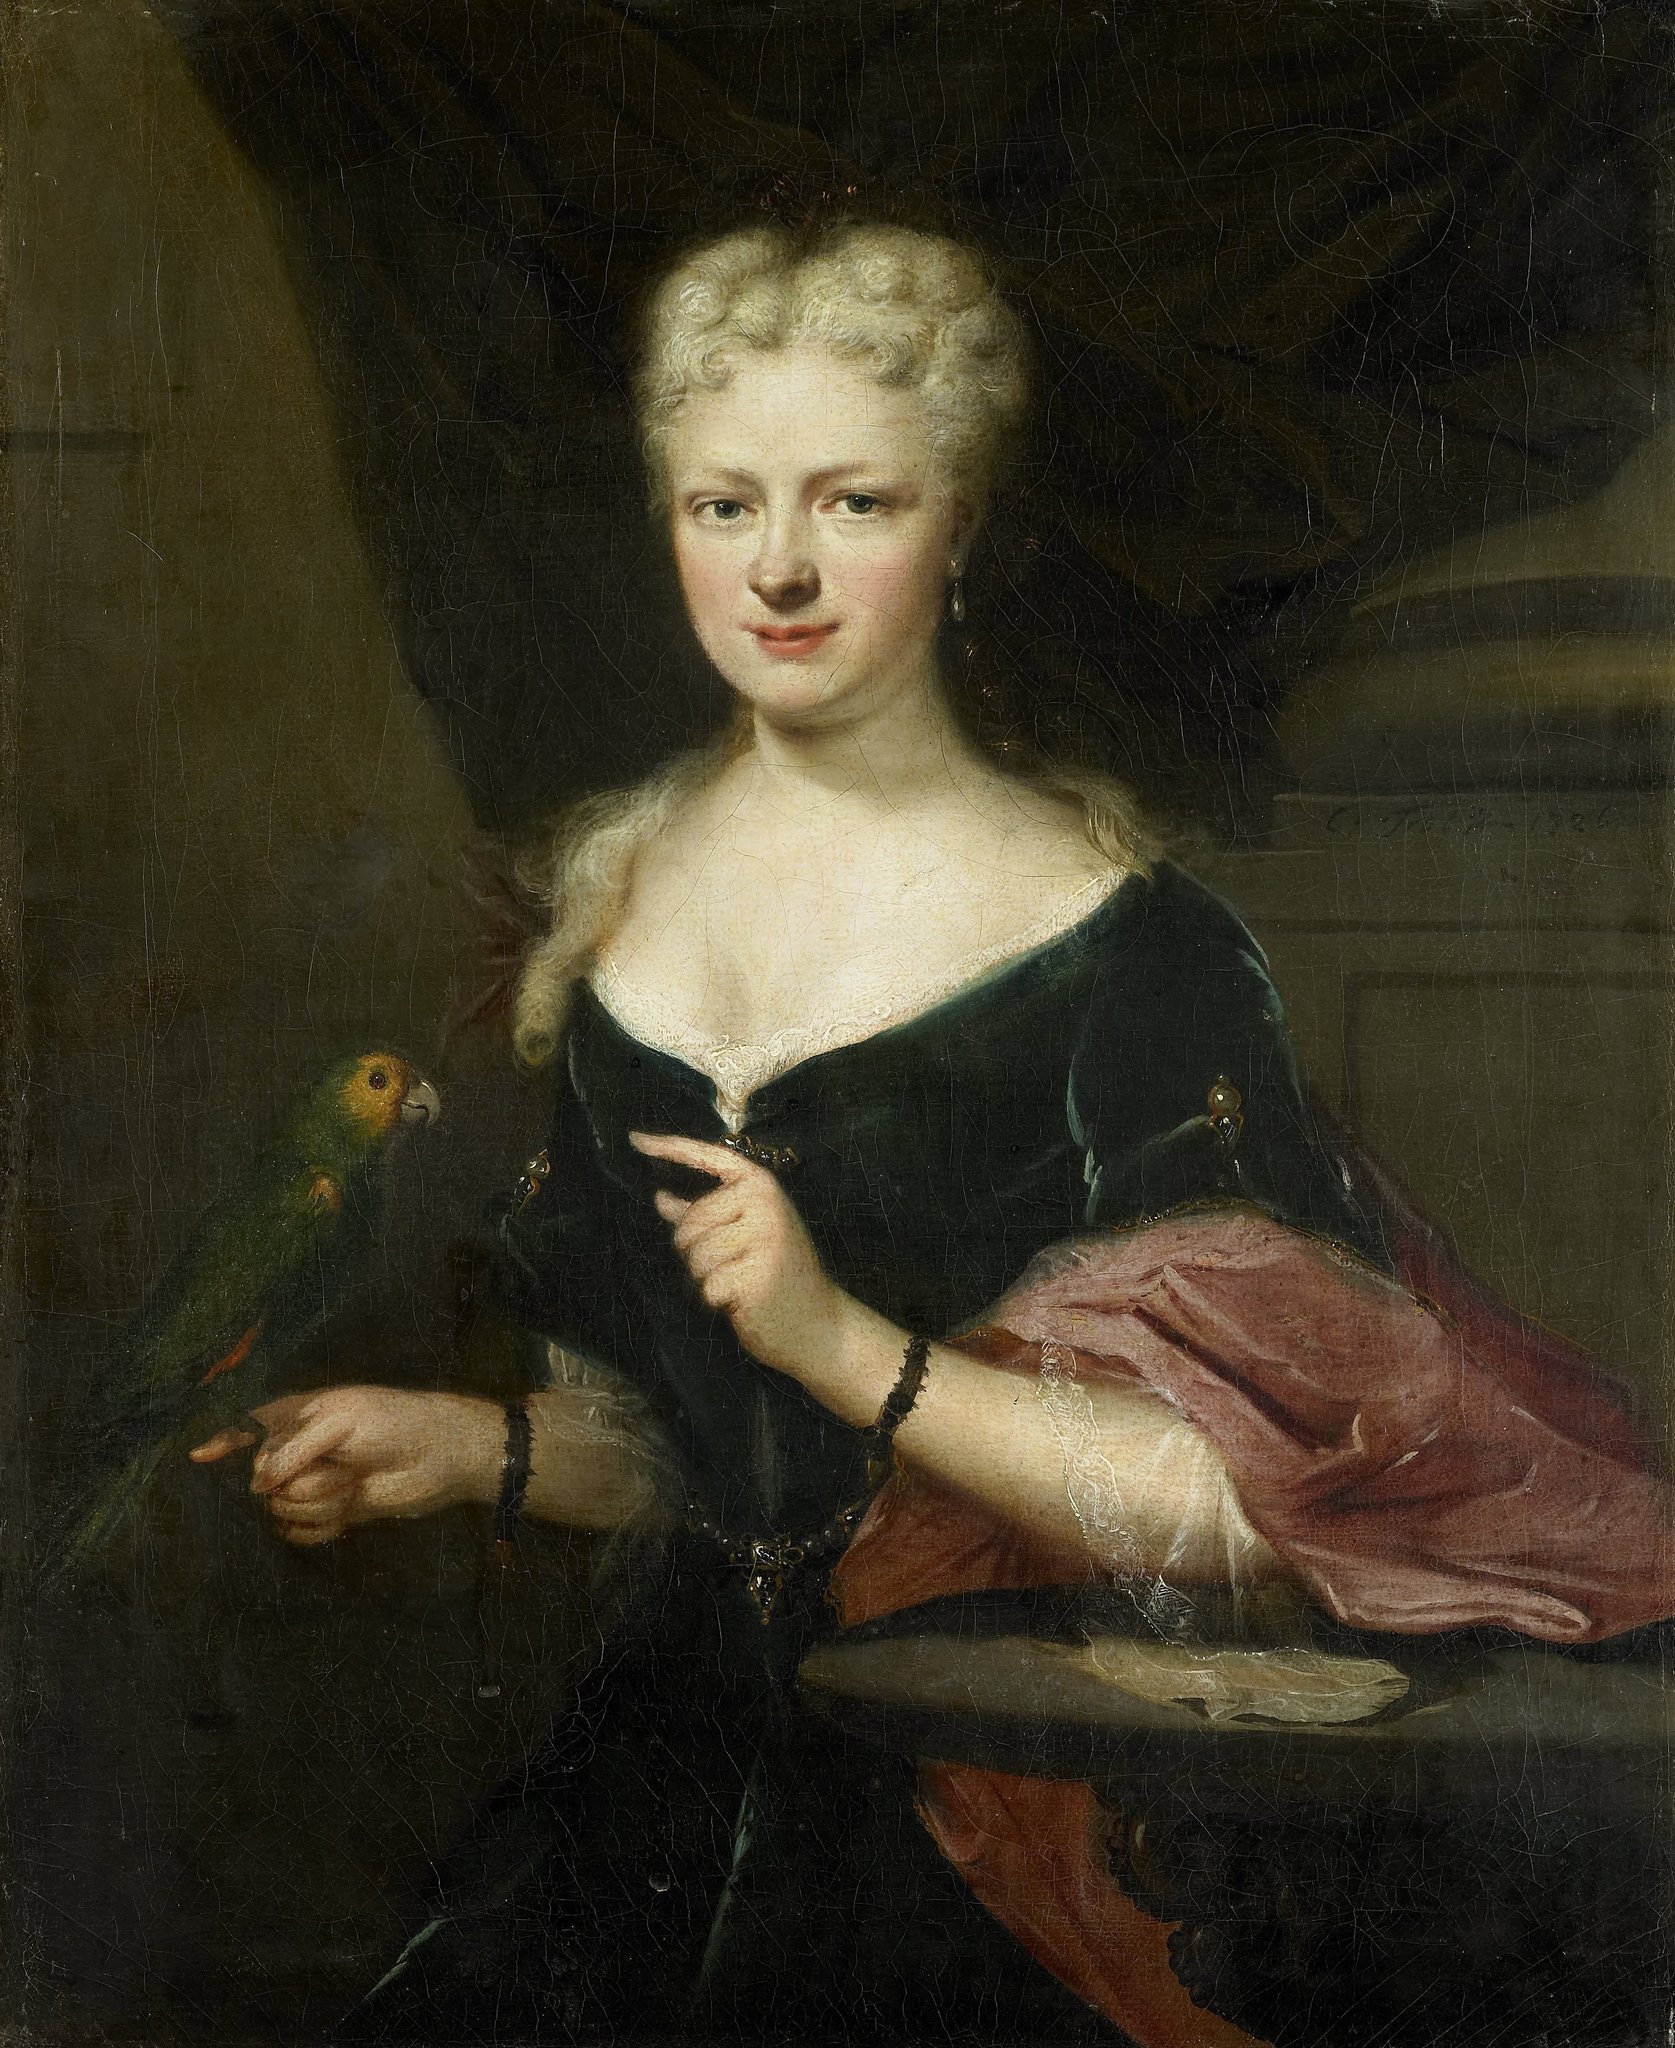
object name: painting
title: Portrait of Maria Magdalena Stavenisse, Wife of Jacob de Witte of Elkerzee, Councilor of Zierikzee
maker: cornelis troost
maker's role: draughtsman, painter, print maker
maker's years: 1696-1750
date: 1726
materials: canvas, oil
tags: historical persons - bb - woman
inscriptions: signature and date: ‘C. Troost 1726’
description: Portret van Maria Magdalena Stavenisse (1700-83), de echtgenote van Jacob de Witte van Elkerzee, raad van Zierikzee. Ten halven lijve, naast aan een tafel met een papegaai op de rechterhand.